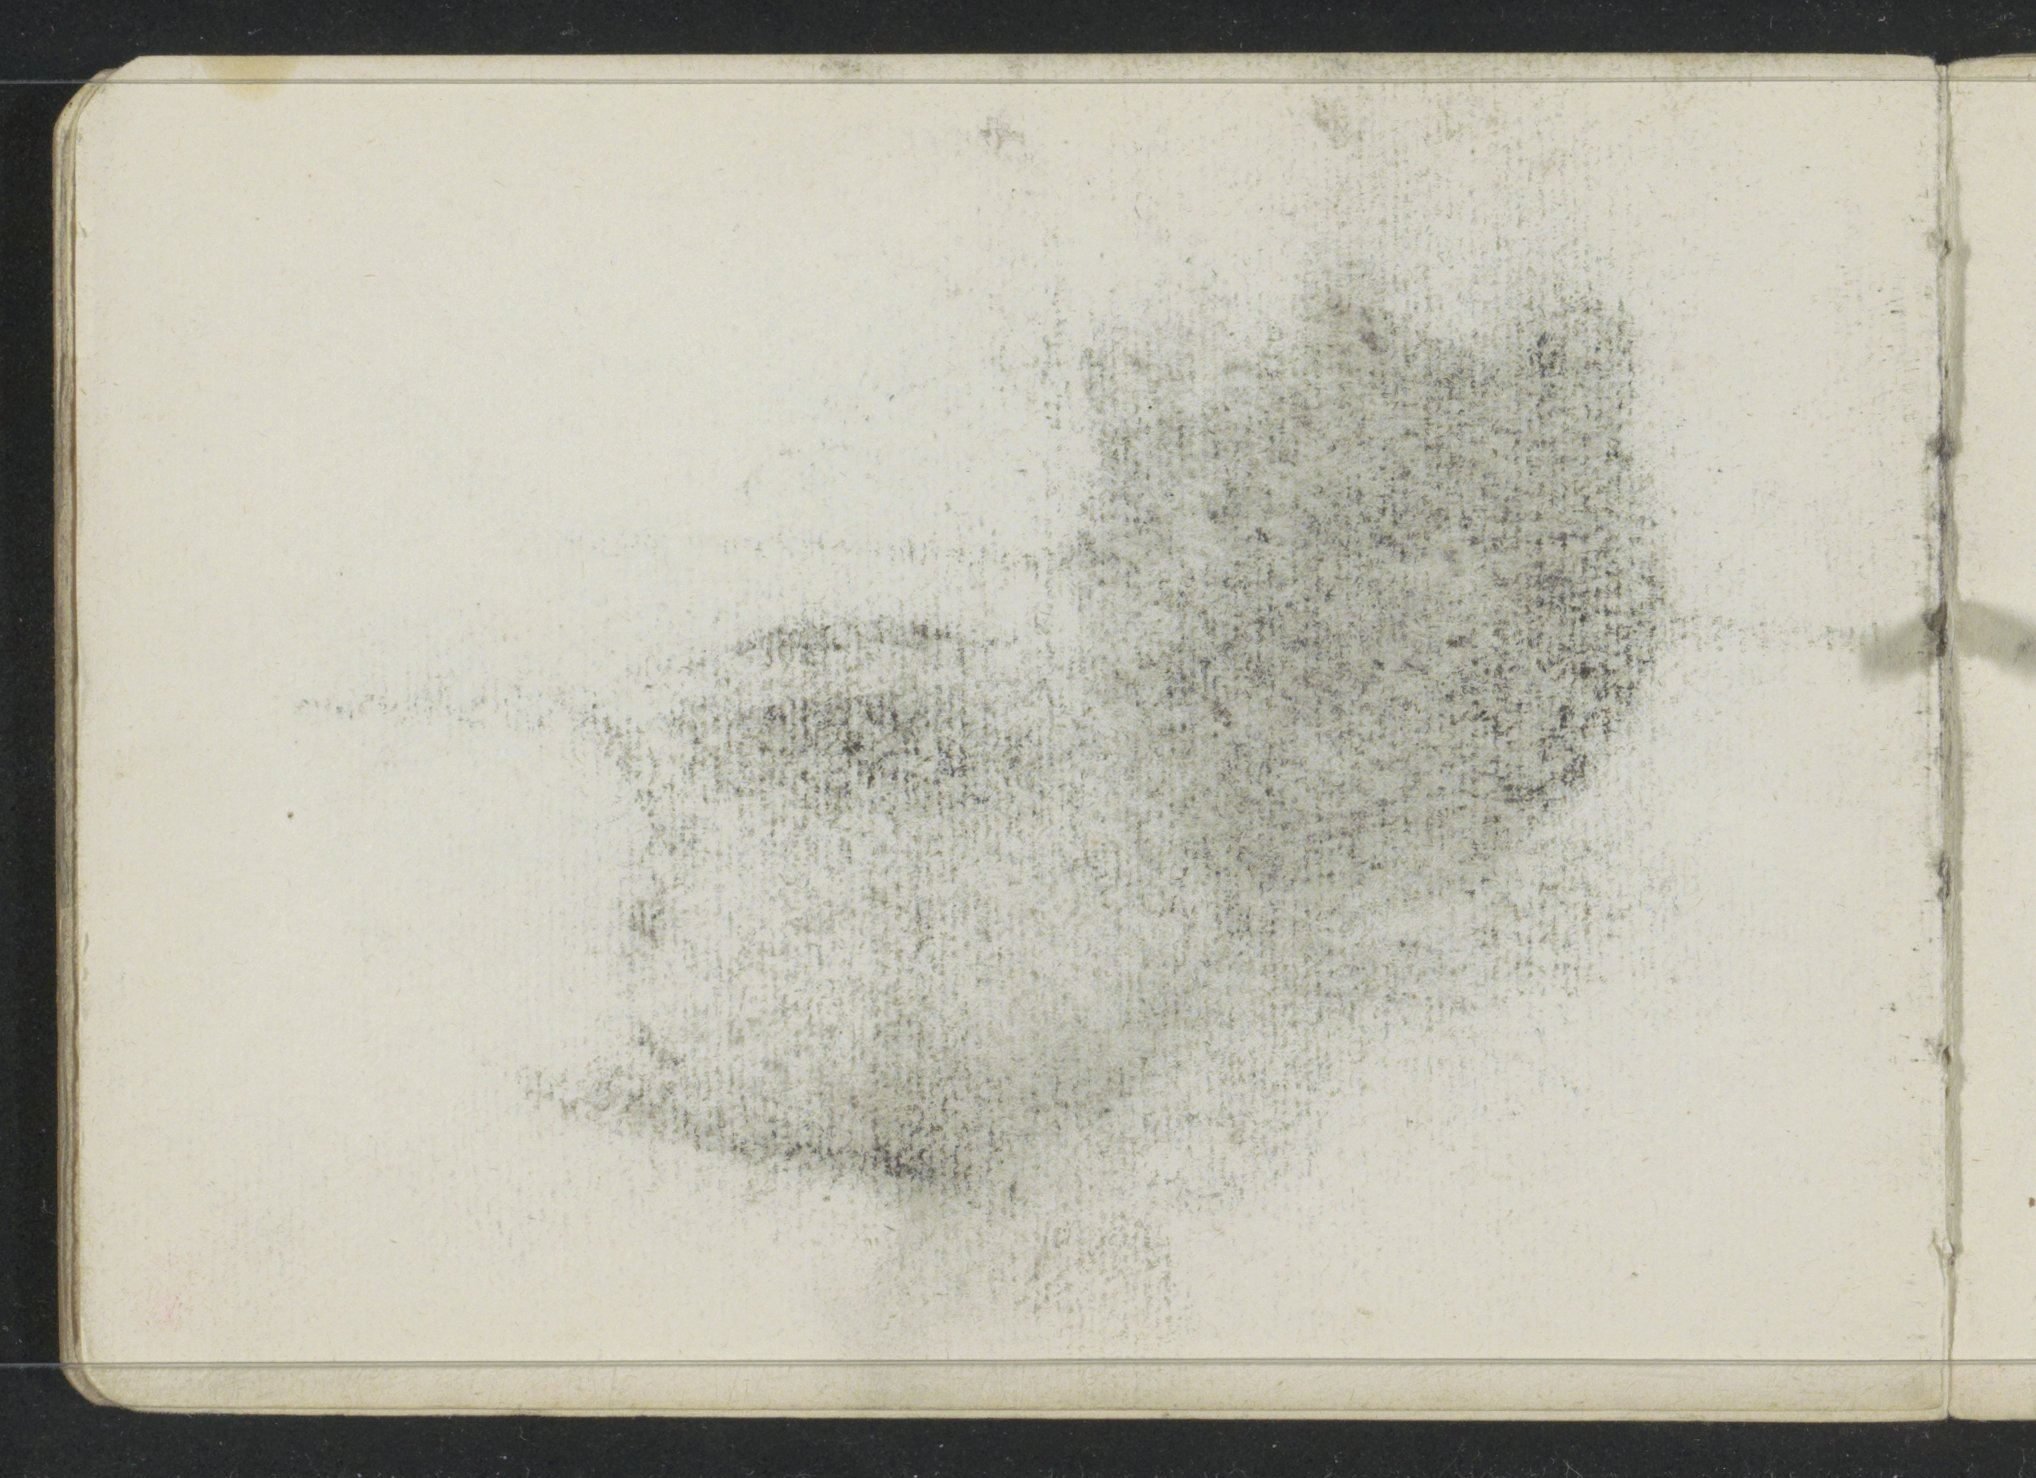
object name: sketchbook leaf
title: Abklatsch van een krijttekening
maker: johanna van de kamer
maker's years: 1873-1922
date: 1883-1922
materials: paper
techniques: printmaking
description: De tekening is niet langer aanwezig in het schetsboek. Blad 4 verso uit een schetsboek met 27 bladen.